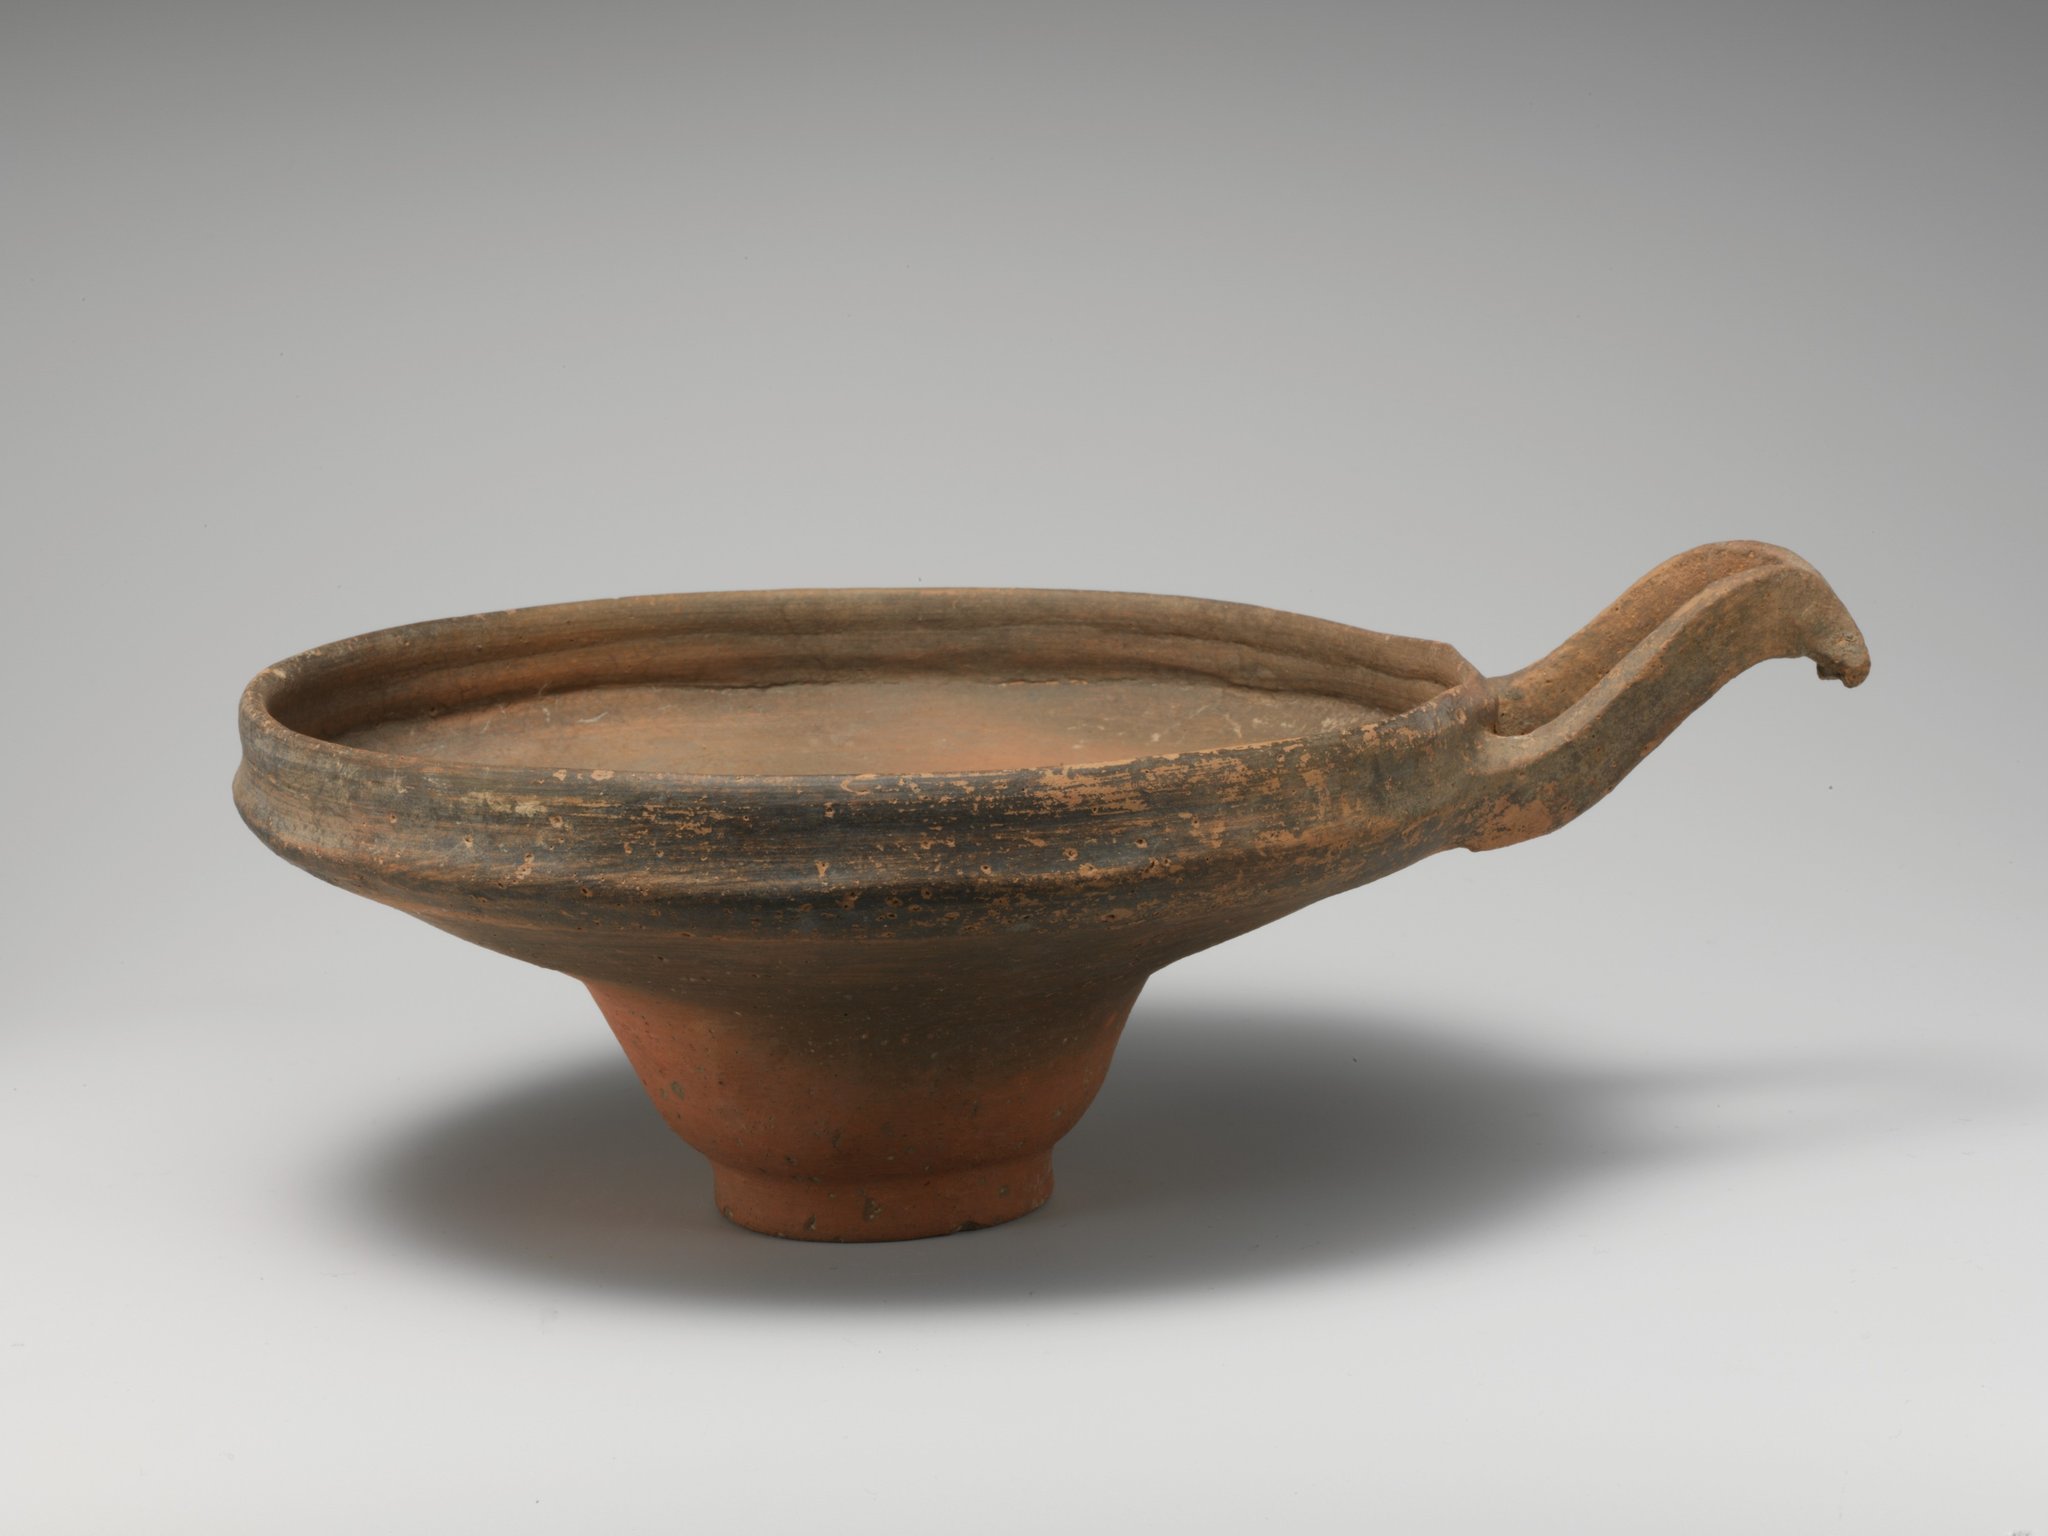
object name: bowl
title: Terracotta bowl with wishbone handle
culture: cypriot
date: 1600-1450 BCE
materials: terracotta